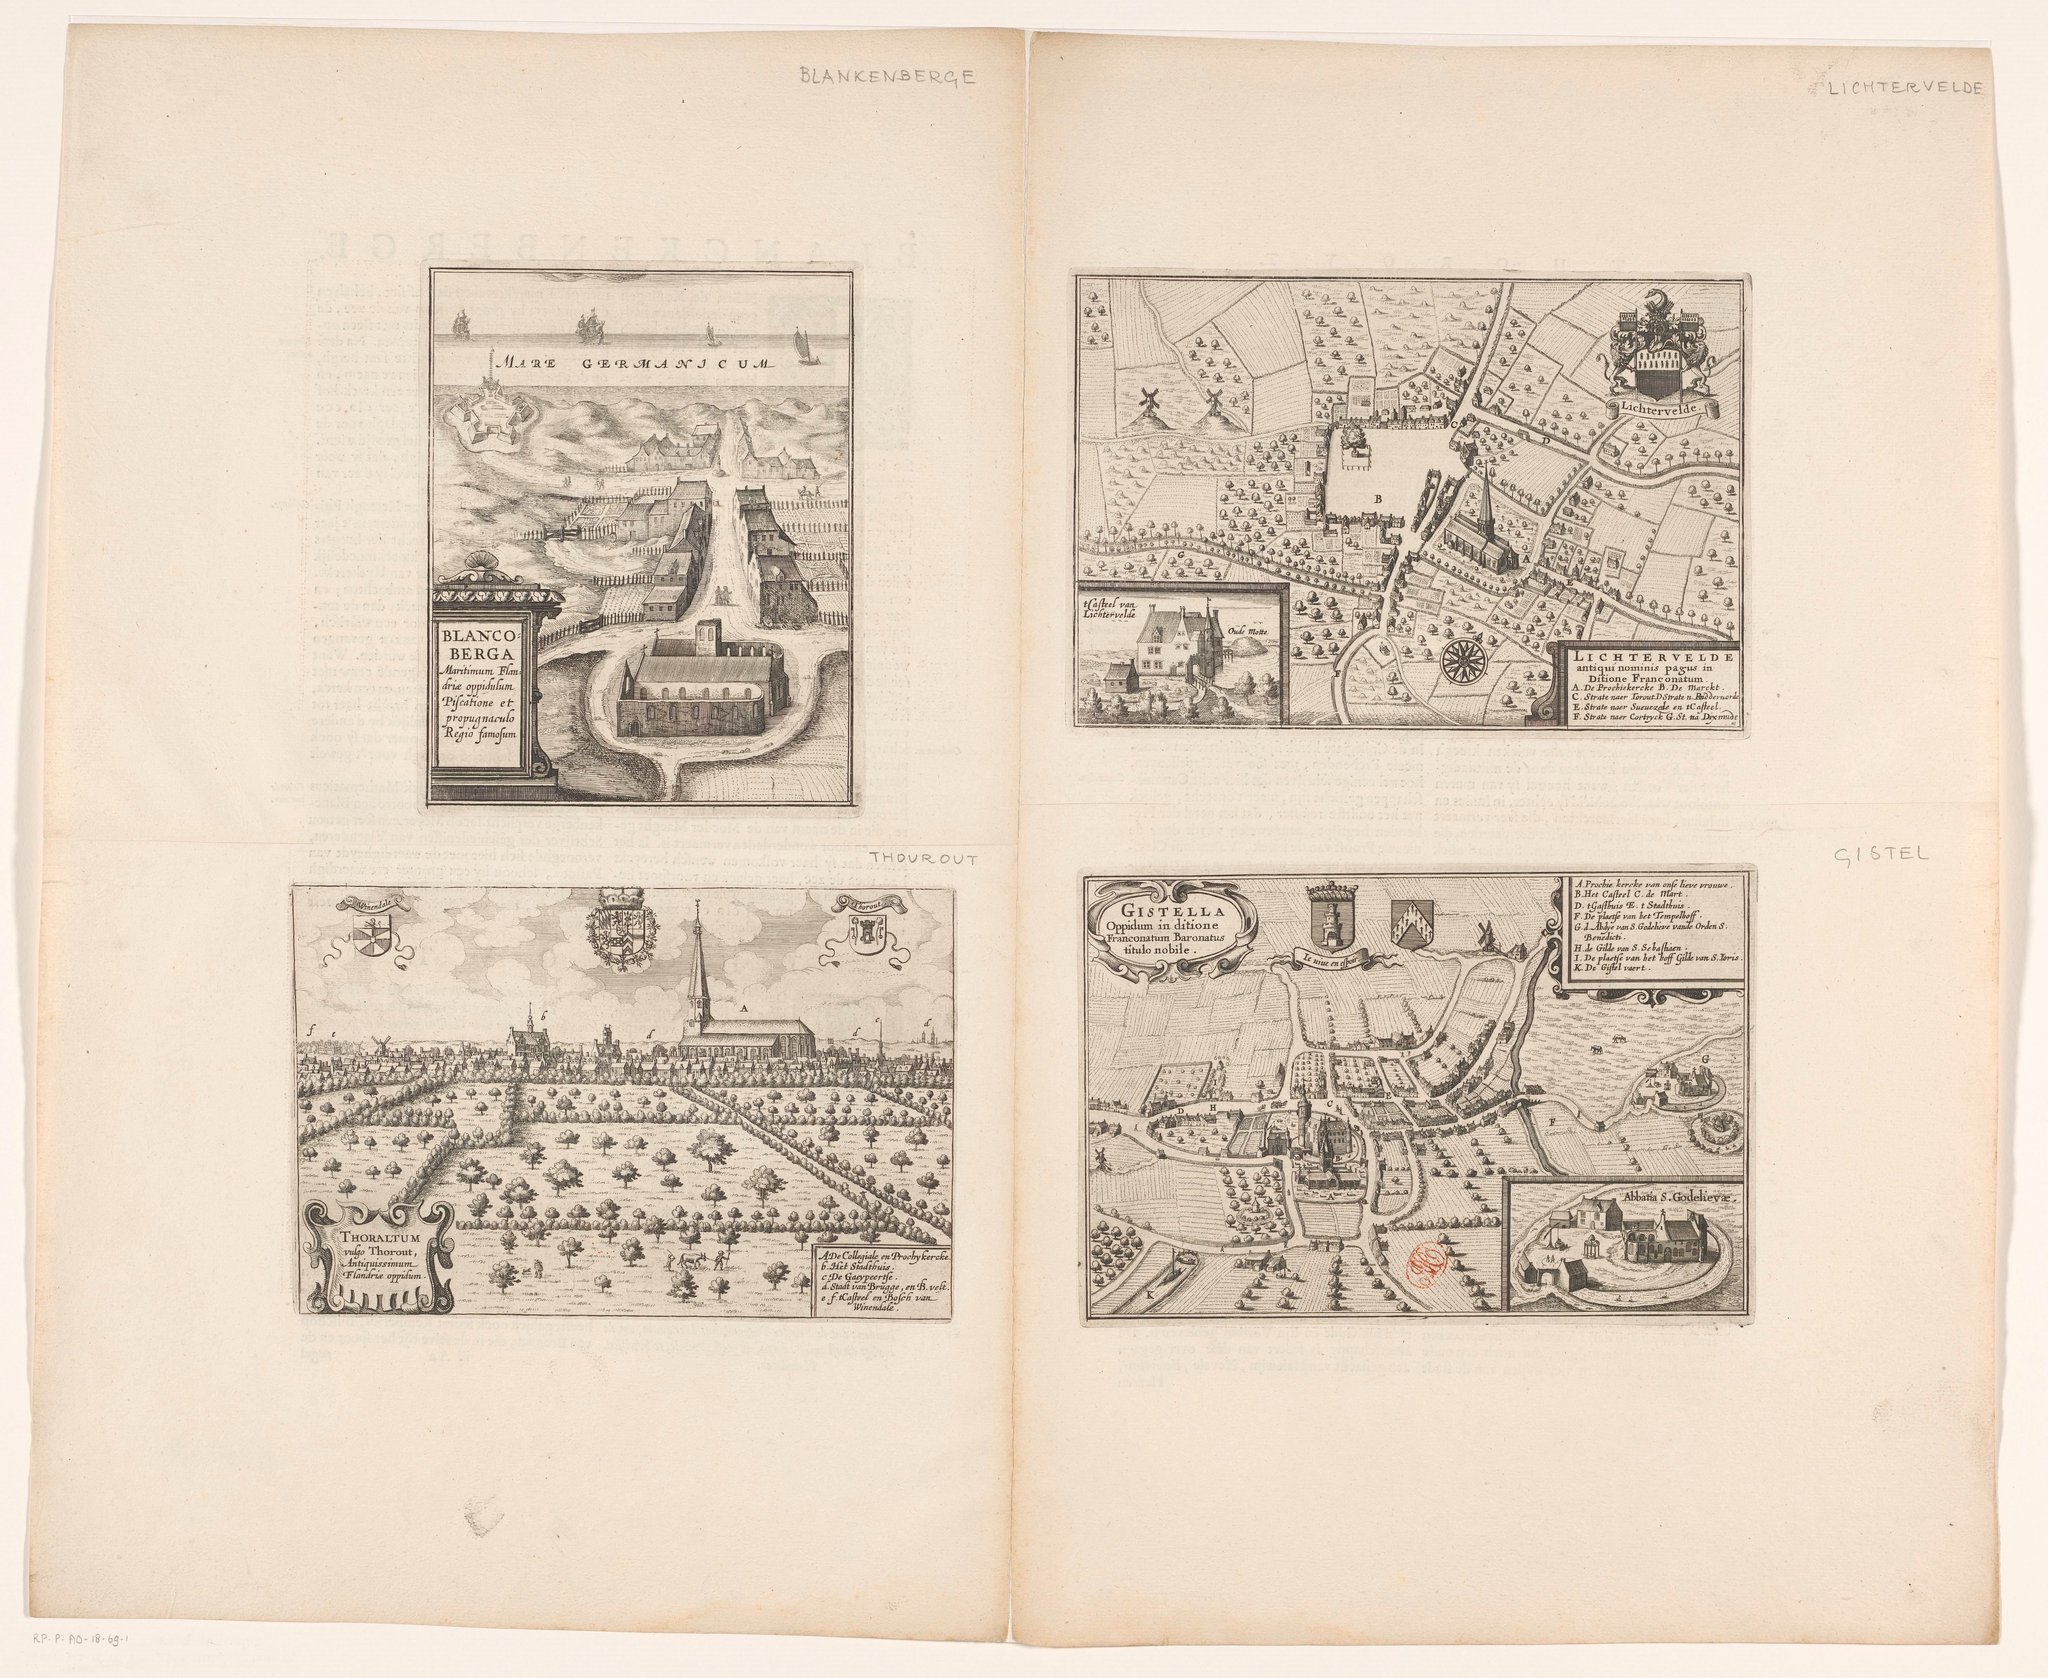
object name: print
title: Blancoberga / Lichtervelde / Thoraltum vulgo Thorout / Gistella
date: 1652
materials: paper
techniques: engraving, etching, letterpress printing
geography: amsterdam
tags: prospect of village, silhouette of village, coat of arms (as symbol of the state, etc.) (+ city; municipal), castle, abbey, monastery, convent ~ roman catholic church, church (exterior), coat of arms (as symbol of the state, etc.) (+ province; provincial), armorial bearing, heraldry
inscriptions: collector's mark: Lugt 195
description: Linksboven een gezicht in vogelvluchtperspectief op Blankenberge, met linksonder de titelcartouche. Rechtsboven een gezicht in vogelvluchtperspectief op Lichtervelde, met rechtsonder een cartouche met titel en legenda A-F. Linksonder een inzet met een gezicht op het Kasteel van Lichtervelde. Rechtsboven het wapen van Lichtervelde. Linksonder een gezicht in vogelvluchtperspectief op Torhout, met linksonder de titelcartouche. Rechtsonder een legenda A-e. Linksboven het wapen van Wijnendale. Boven, in het midden, het wapen van Wolfgang Willem van Palts-Neuburg. Rechtsboven het wapen van Torhout. Linksonder een gezicht in vogelvluchtperspectief op Gistel, met linksboven de titelcartouche. Rechts hiervan het wapen van de familie D'Affaytadi en weer rechts hiervan het wapen van Gistel. Rechtsboven een cartouche met legenda A-K. Rechtsonder een kader met gezicht op de Abdij Ten Putte, ook wel Sint-Godelieveabdij. Met Nederlandse tekst op verso.